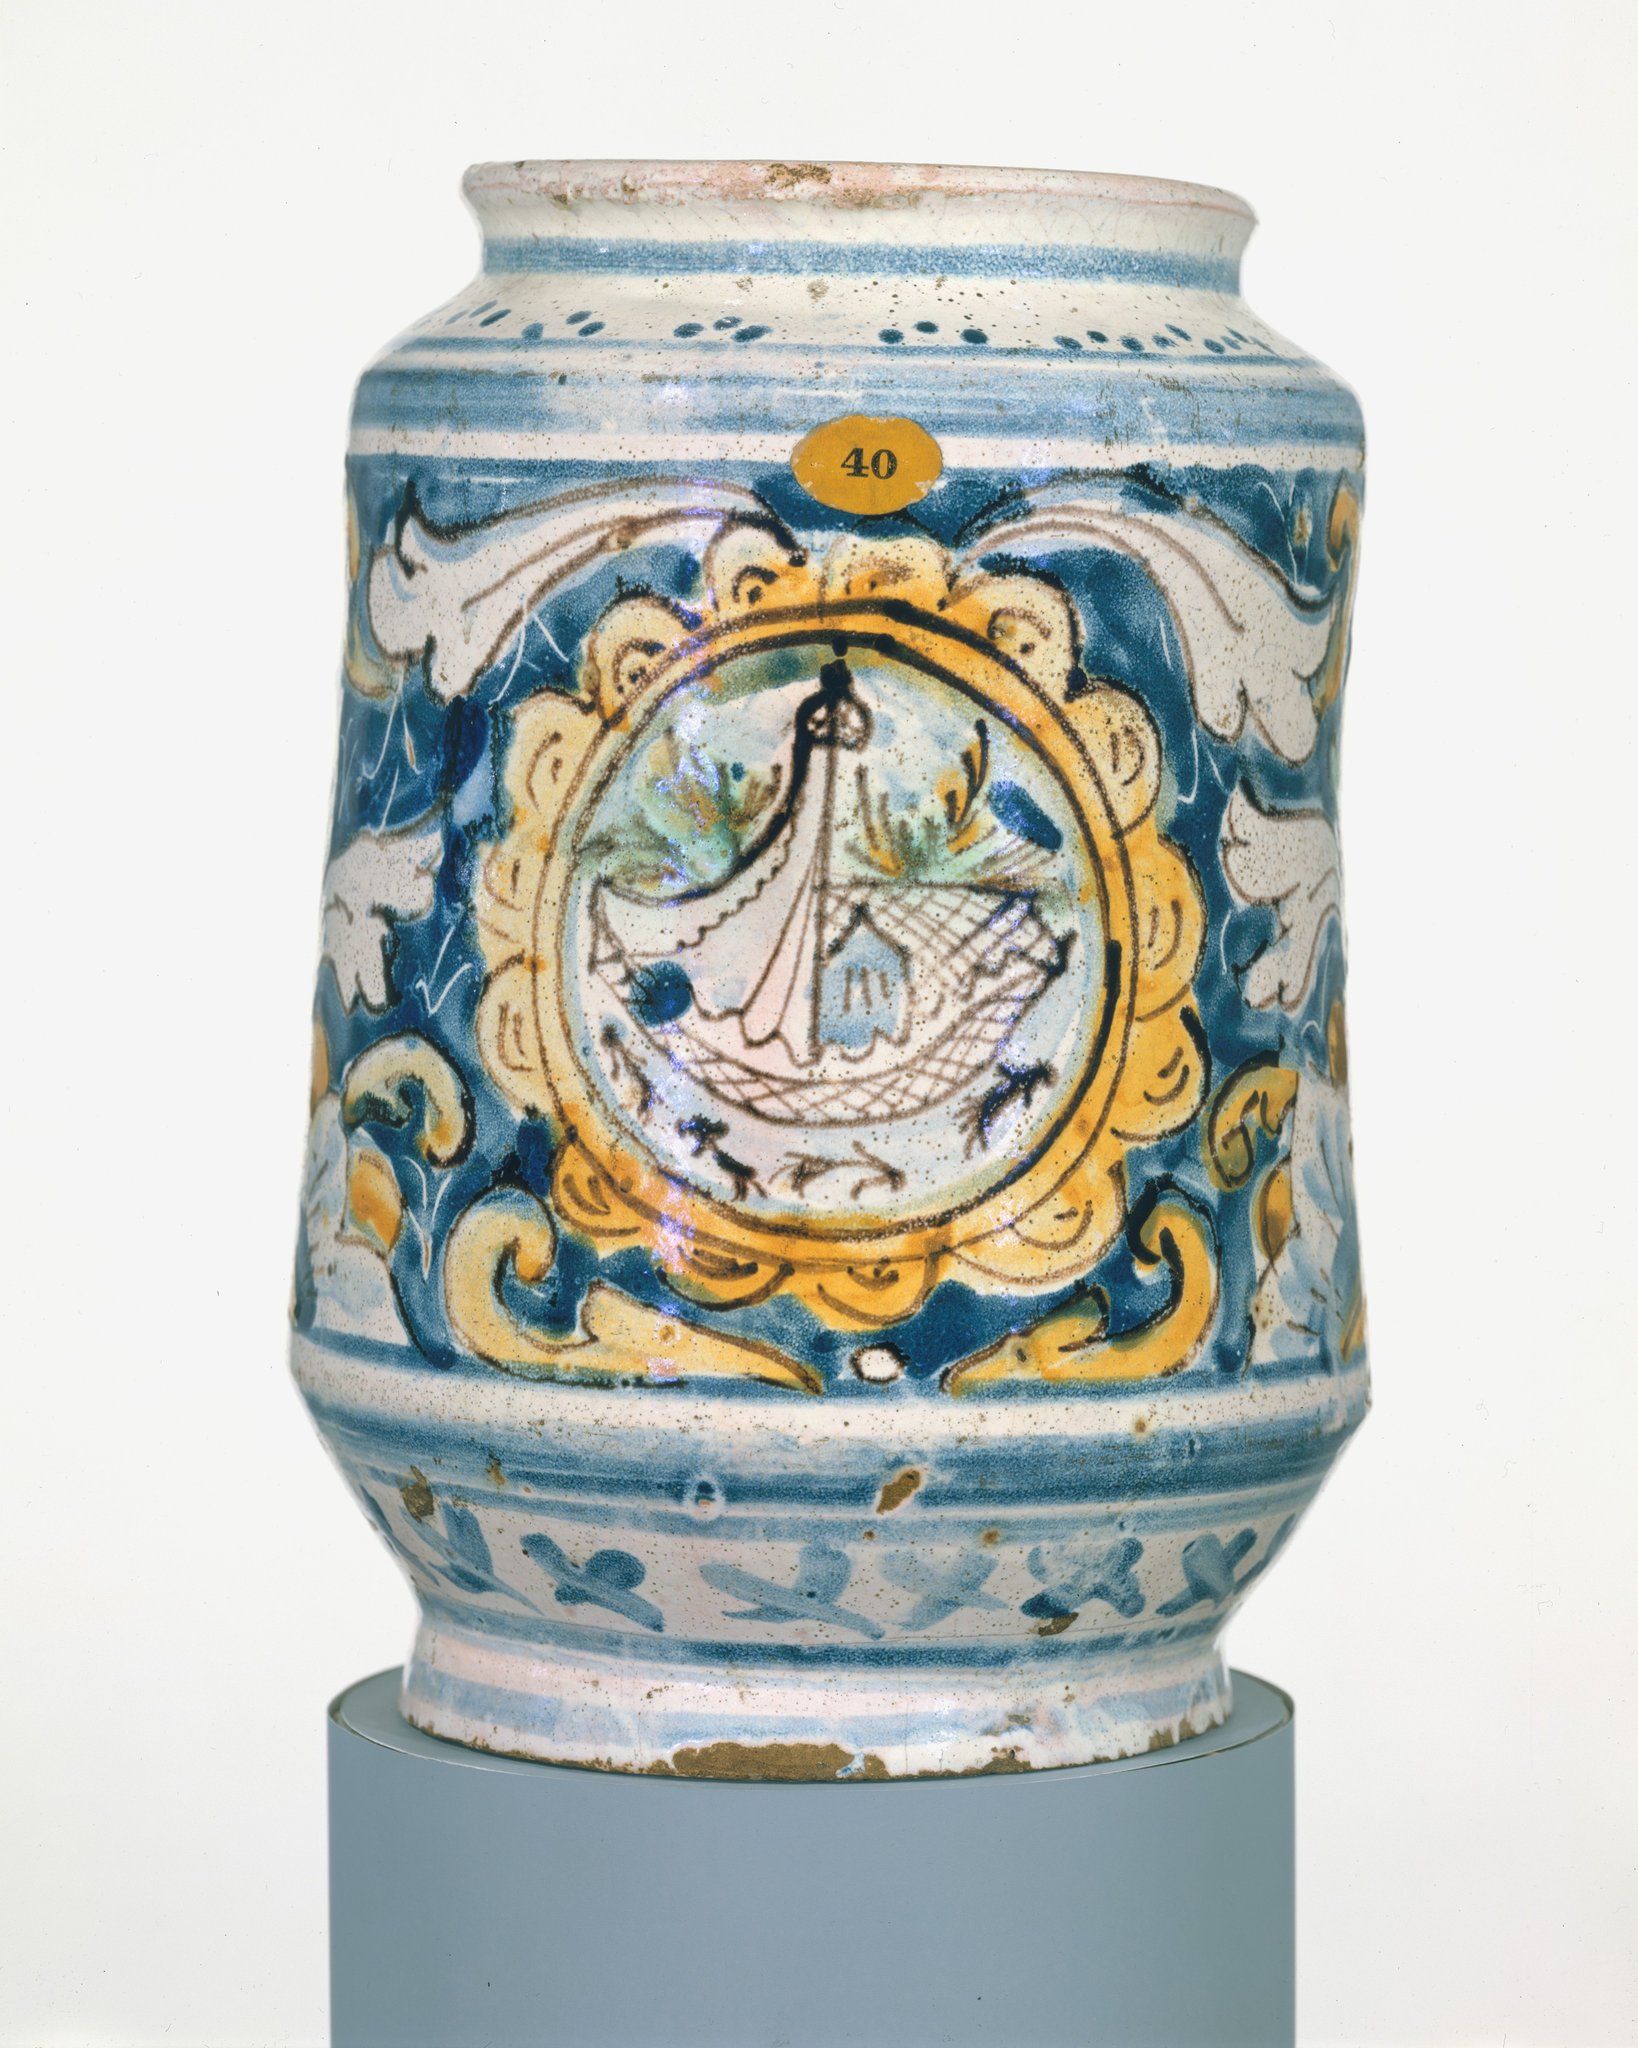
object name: albarello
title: Apothecary jar (albarello)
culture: italian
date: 1601-1700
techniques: maiolica, glazing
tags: ships